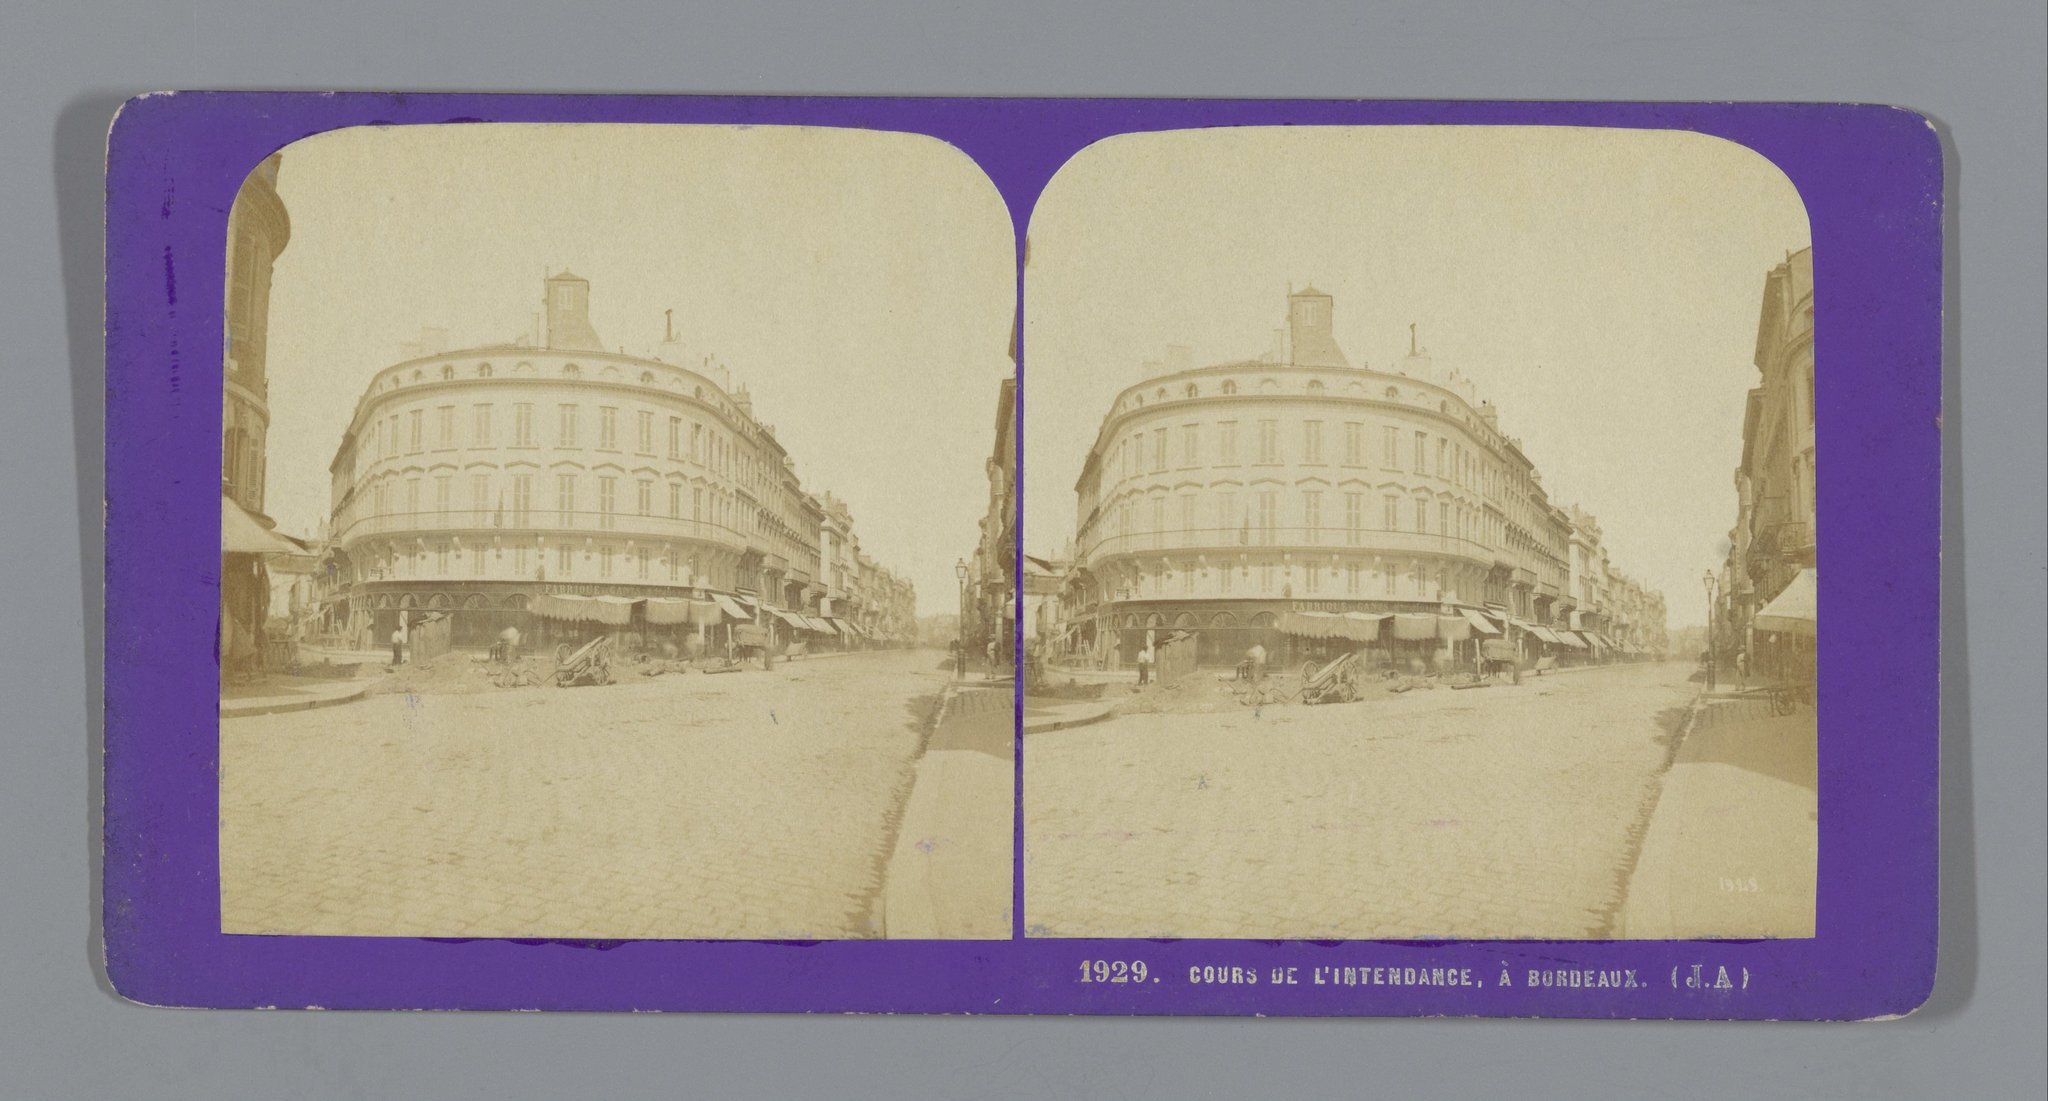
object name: stereograph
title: Cours de l'Intendance, à Bordeaux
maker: jean andrieu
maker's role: fotograaf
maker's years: 1816-1872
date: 1862-1876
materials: cardboard, photographic support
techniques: albumen print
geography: bordeaux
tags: façade (of house or building), street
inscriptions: number: ‘1929’